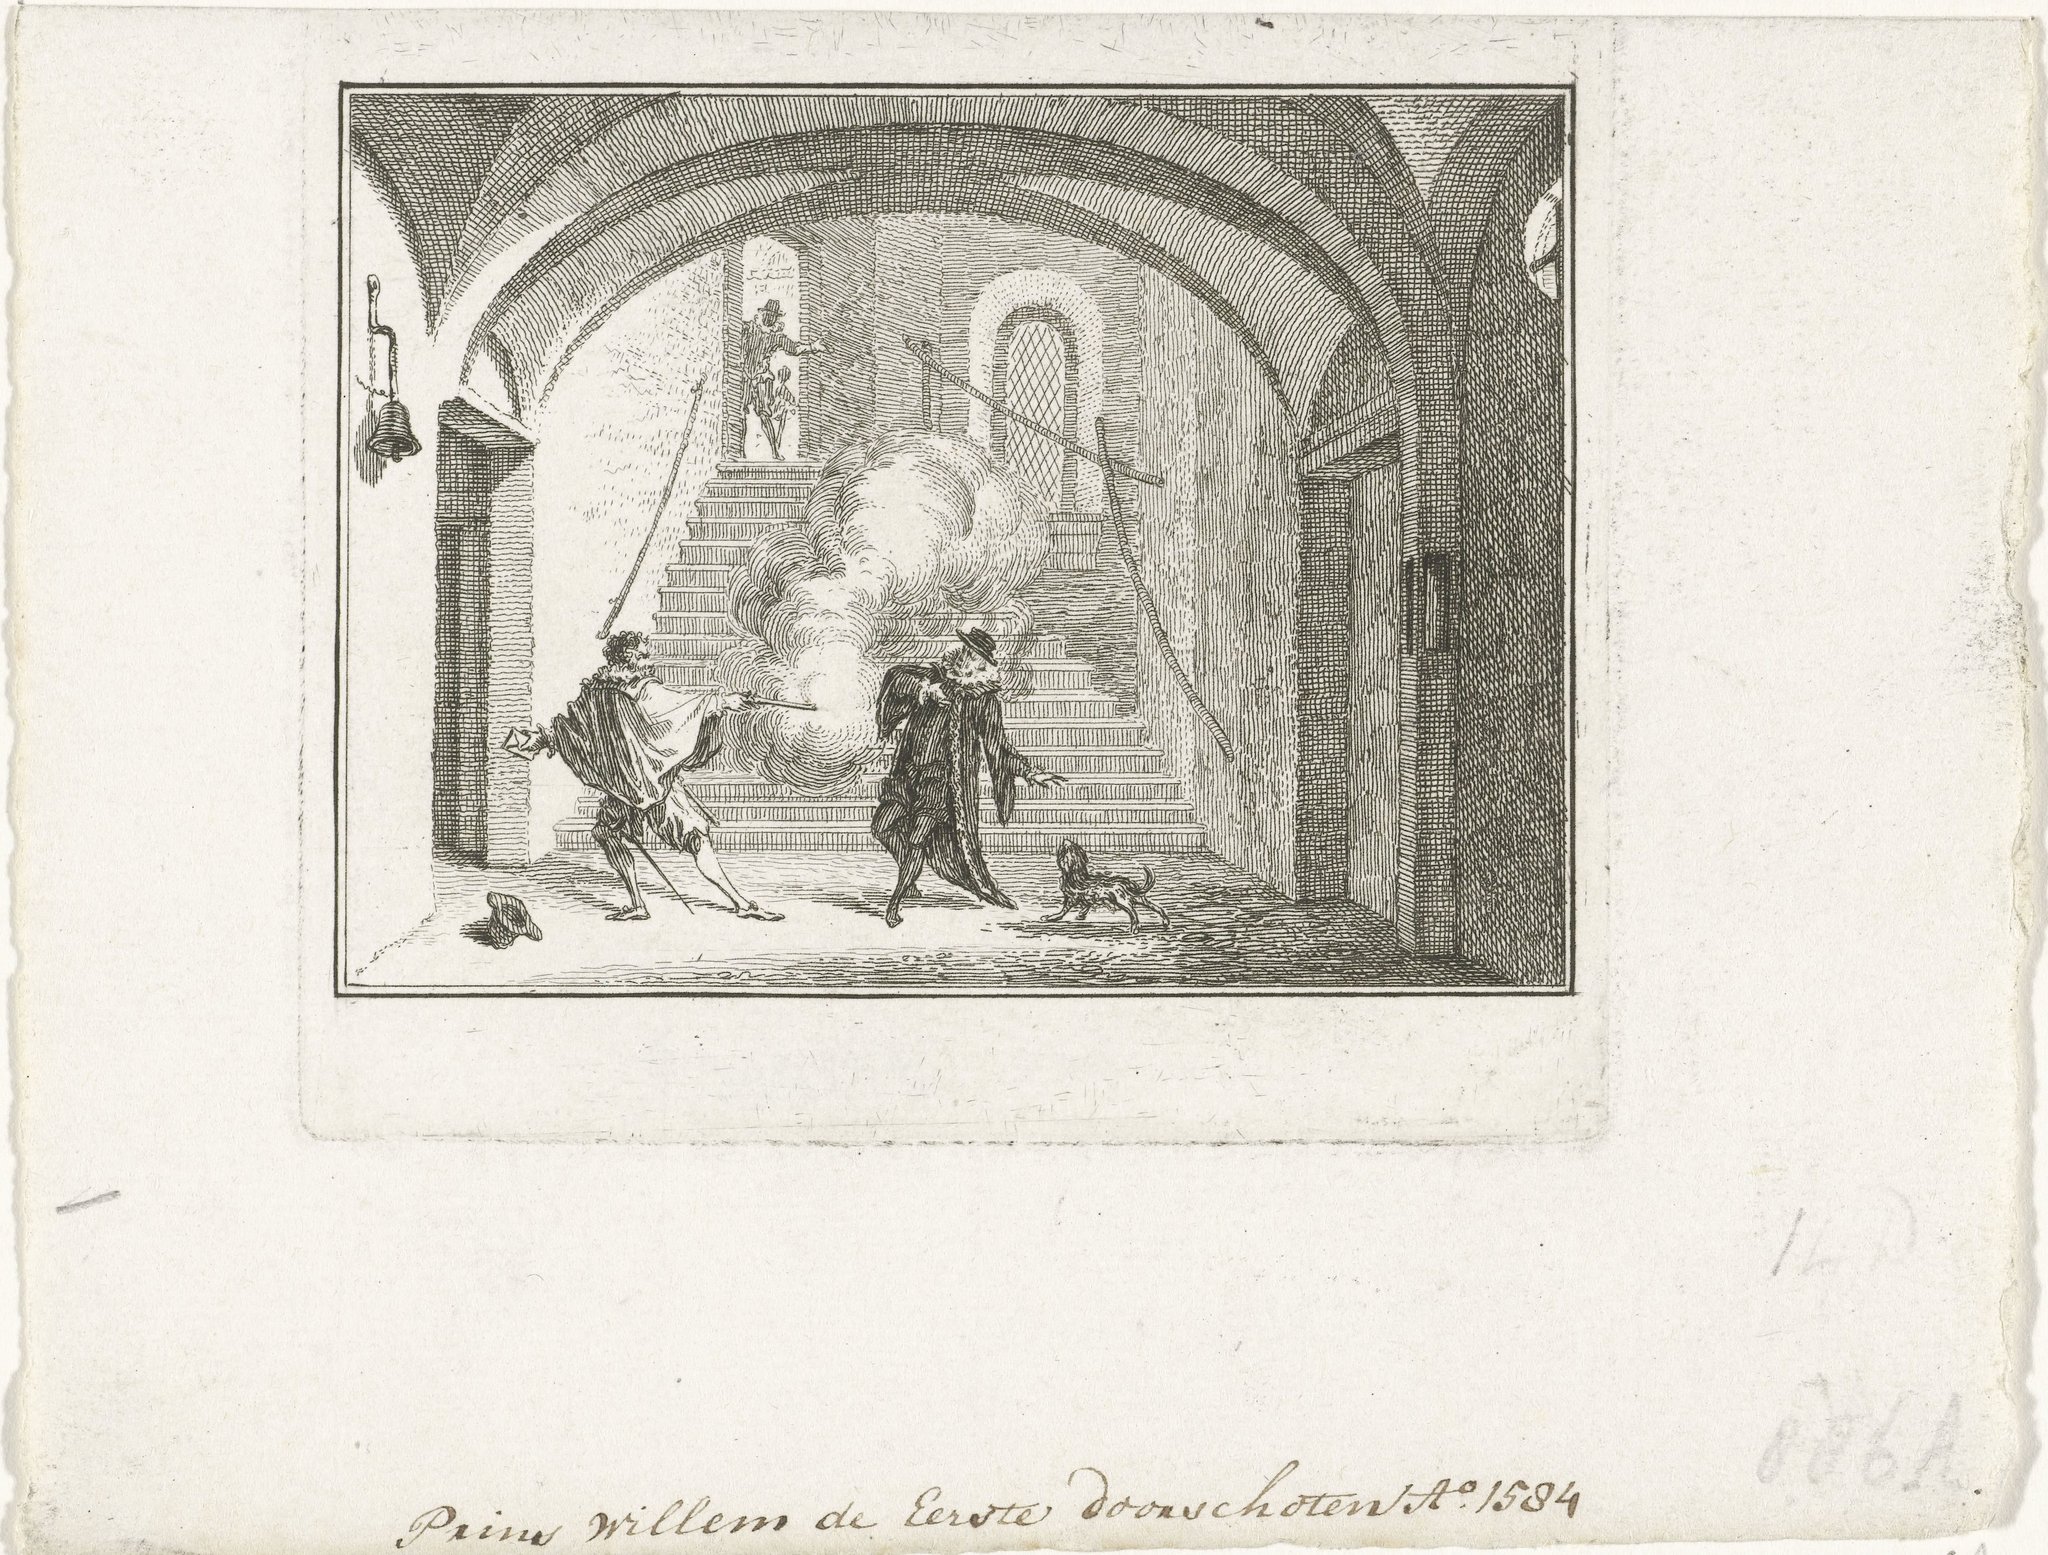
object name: history print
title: De moord op Willem van Oranje, 1584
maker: simon fokke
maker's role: draughtsman, print maker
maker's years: 1712-1784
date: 1782-1784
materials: paper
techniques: etching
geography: northern netherlands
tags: delft, william i (prince of orange), attempt, political murder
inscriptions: inscription: ‘Prins Willem de Eerste doorschoten Ao. 1584’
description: Gebruikt als illustratie in: J.W. te Water, De vaderlandsche Historie van den heere J. Wagenaar, verkort, en met leerzaame aanmerkingen, ten dienste der Nederlandsche jeugd, 1784-1800, 4 delen. Niet in Frederik Muller; door het RPK toegevoegd nummer.